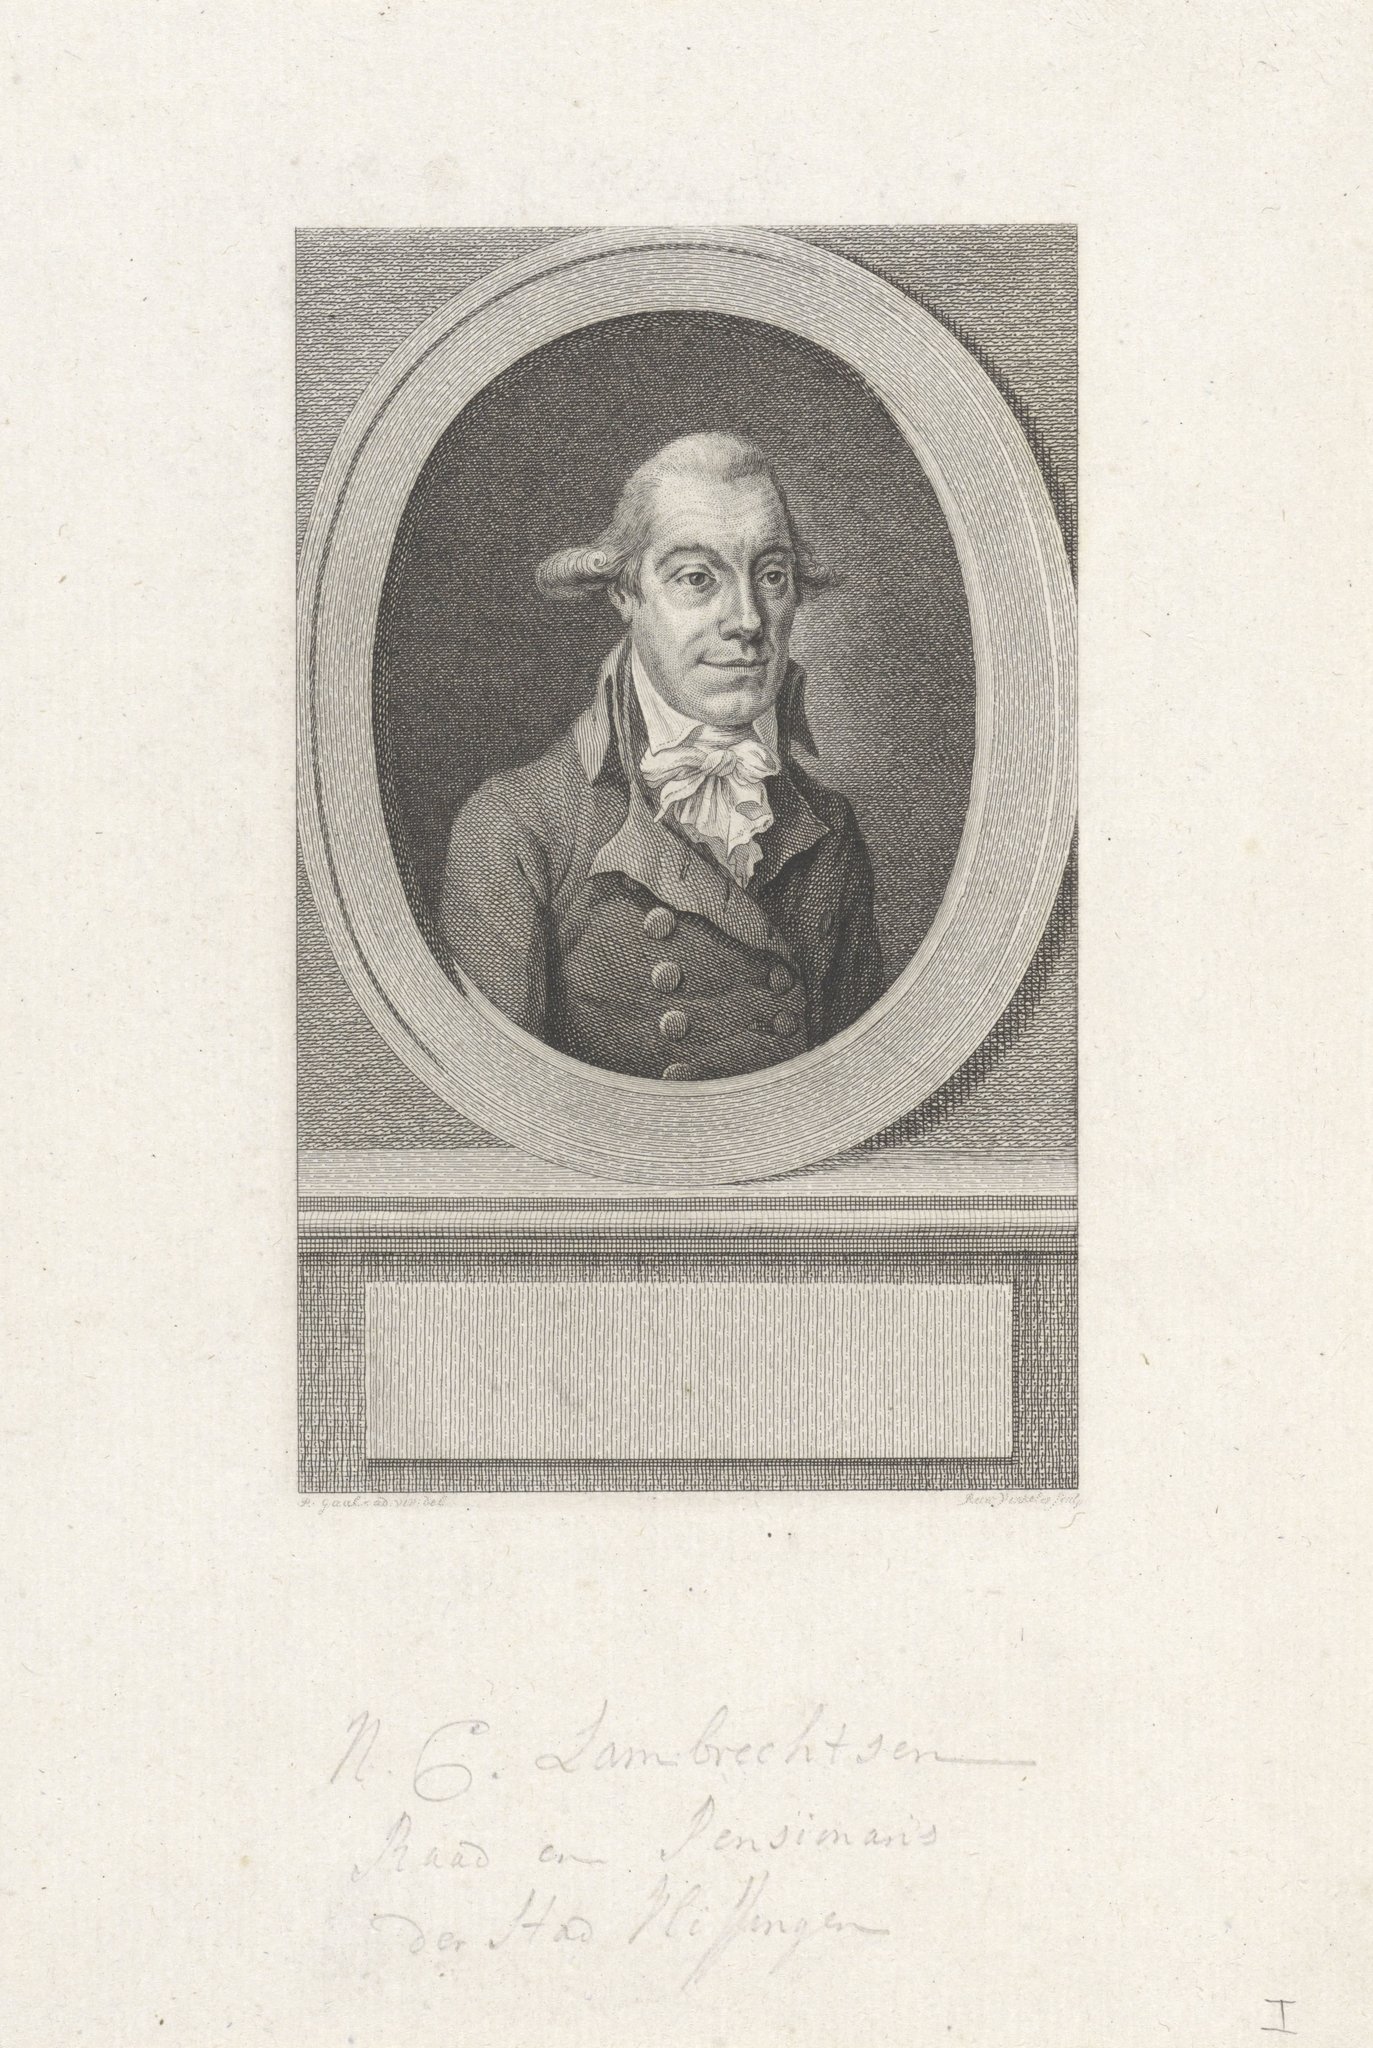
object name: print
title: Portret van Nicolaas Cornelis Lambrechtsen van Ritthem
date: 1794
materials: paper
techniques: etching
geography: amsterdam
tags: middelburg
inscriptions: collector's mark: Lugt 240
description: Latere staat prent ook gebruikt als boekillustratie in: Wagenaar, Jan. Vaderlandsche historie, (...) ten vervolge van Wagenaars Vaderlandsche historie. Dl. 1-43. Amsterdam: Johannes Allart, 1786-1809.